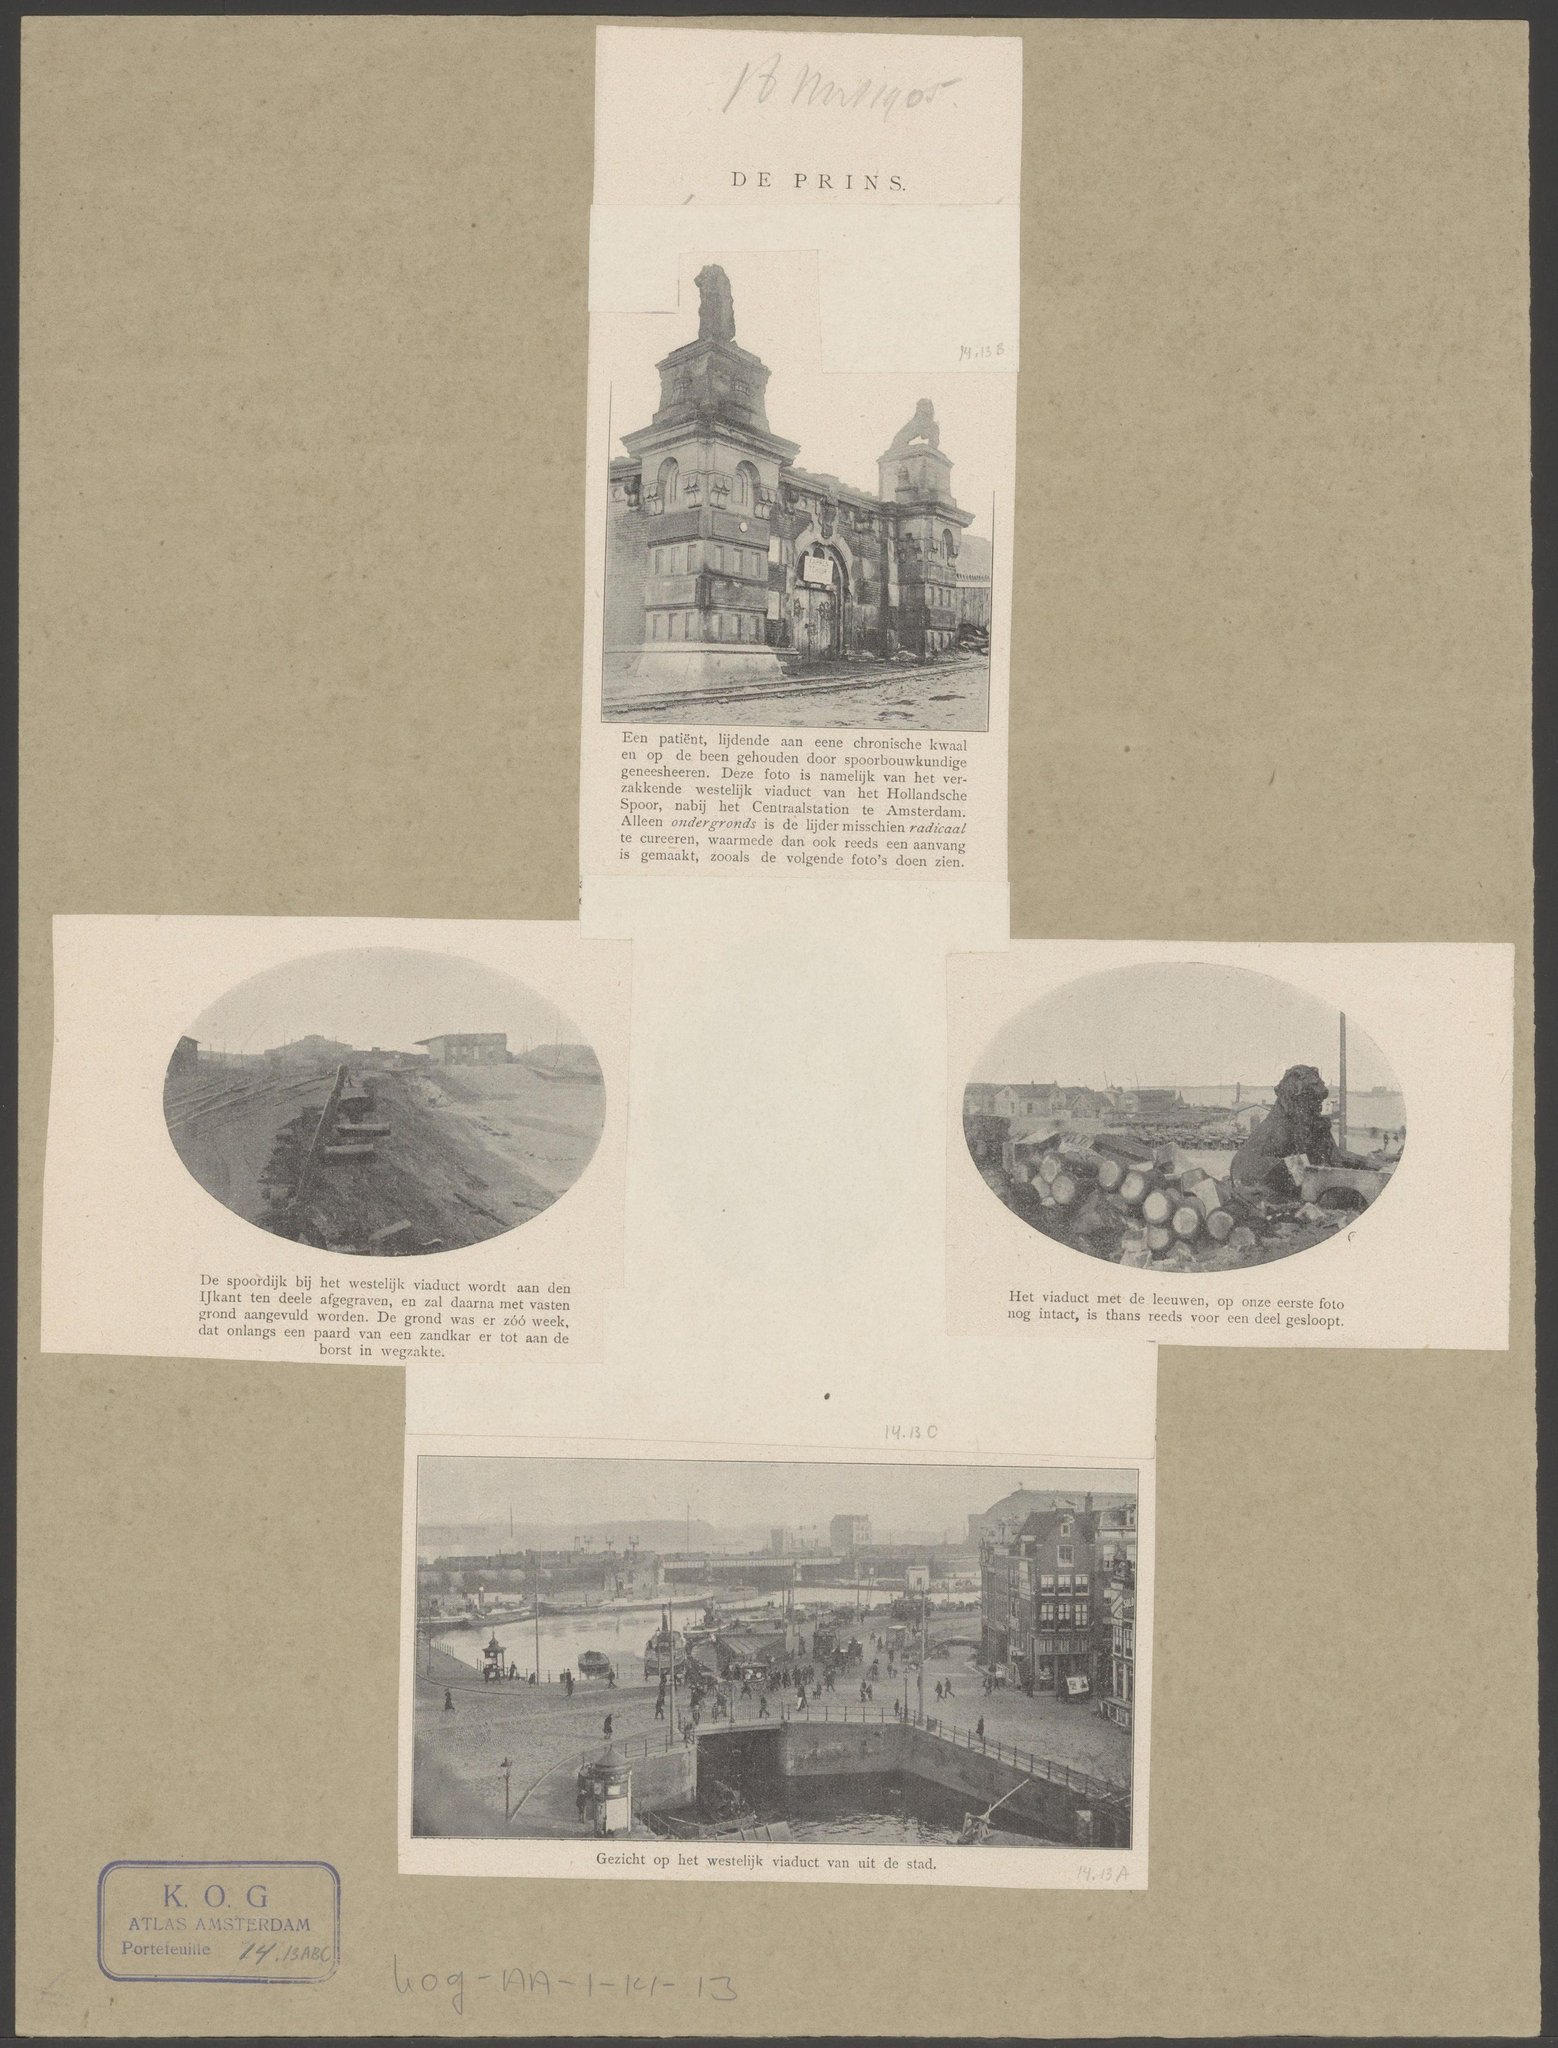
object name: photomechanical print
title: Gezichten op de sloop en bouw van het westelijk viaduct vlakbij het Station Amsterdam Centraal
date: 1905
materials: paper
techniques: letterpress printing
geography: amsterdam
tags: viaduct, city-view in general; 'veduta', railway, train, building-site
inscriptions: collector's mark: ‘14.13ABC’ Lugt 1641b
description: Onderwerpsrubriek binnen de Atlas Amsterdam: Verhulststraat (Johannes), Viaducten, Vierwindenstraat, Vinkenbuurt, Vinkenpad, Vinkenstraat, Vischsteeg, Vliegendesteeg, Voetboogstraat, Volewijk, Vondelstraat, Voorburgwal (N.Z.).